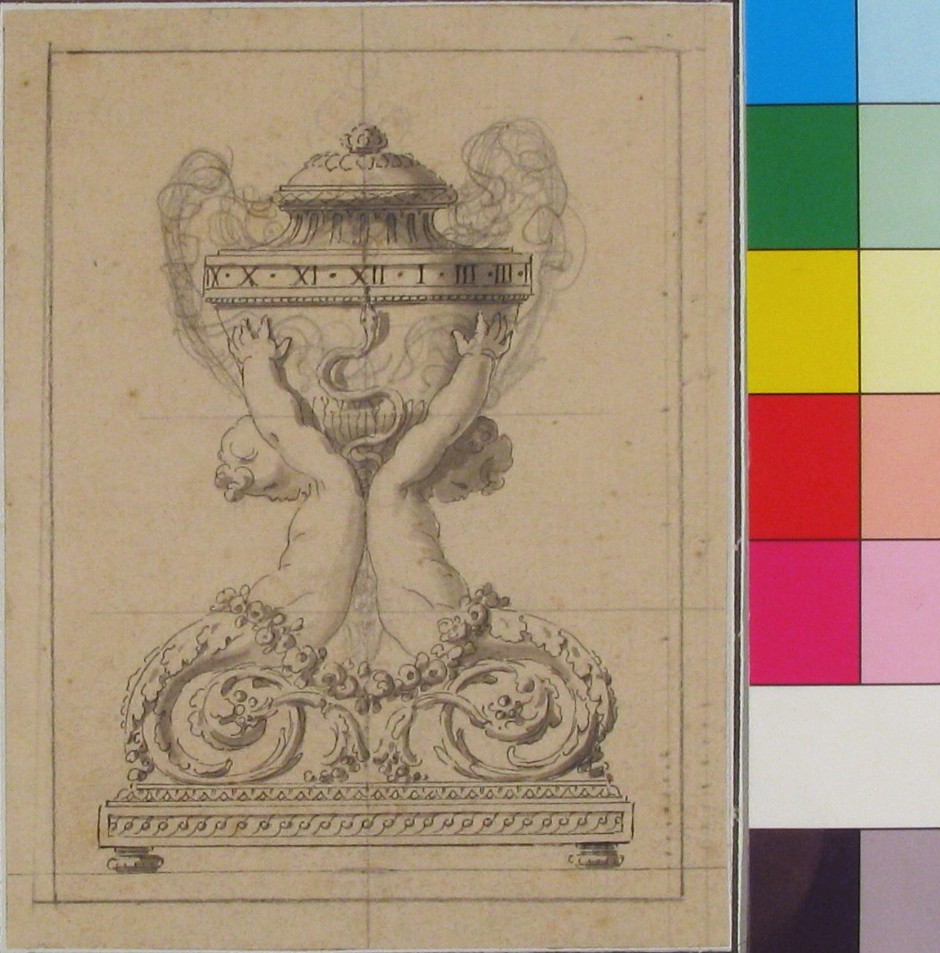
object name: drawing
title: Design for a Clock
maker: jean françois forty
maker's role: artist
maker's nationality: french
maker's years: 1775-1790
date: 1770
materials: graphite, ink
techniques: brush, pen, wash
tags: putti,clocks,urns